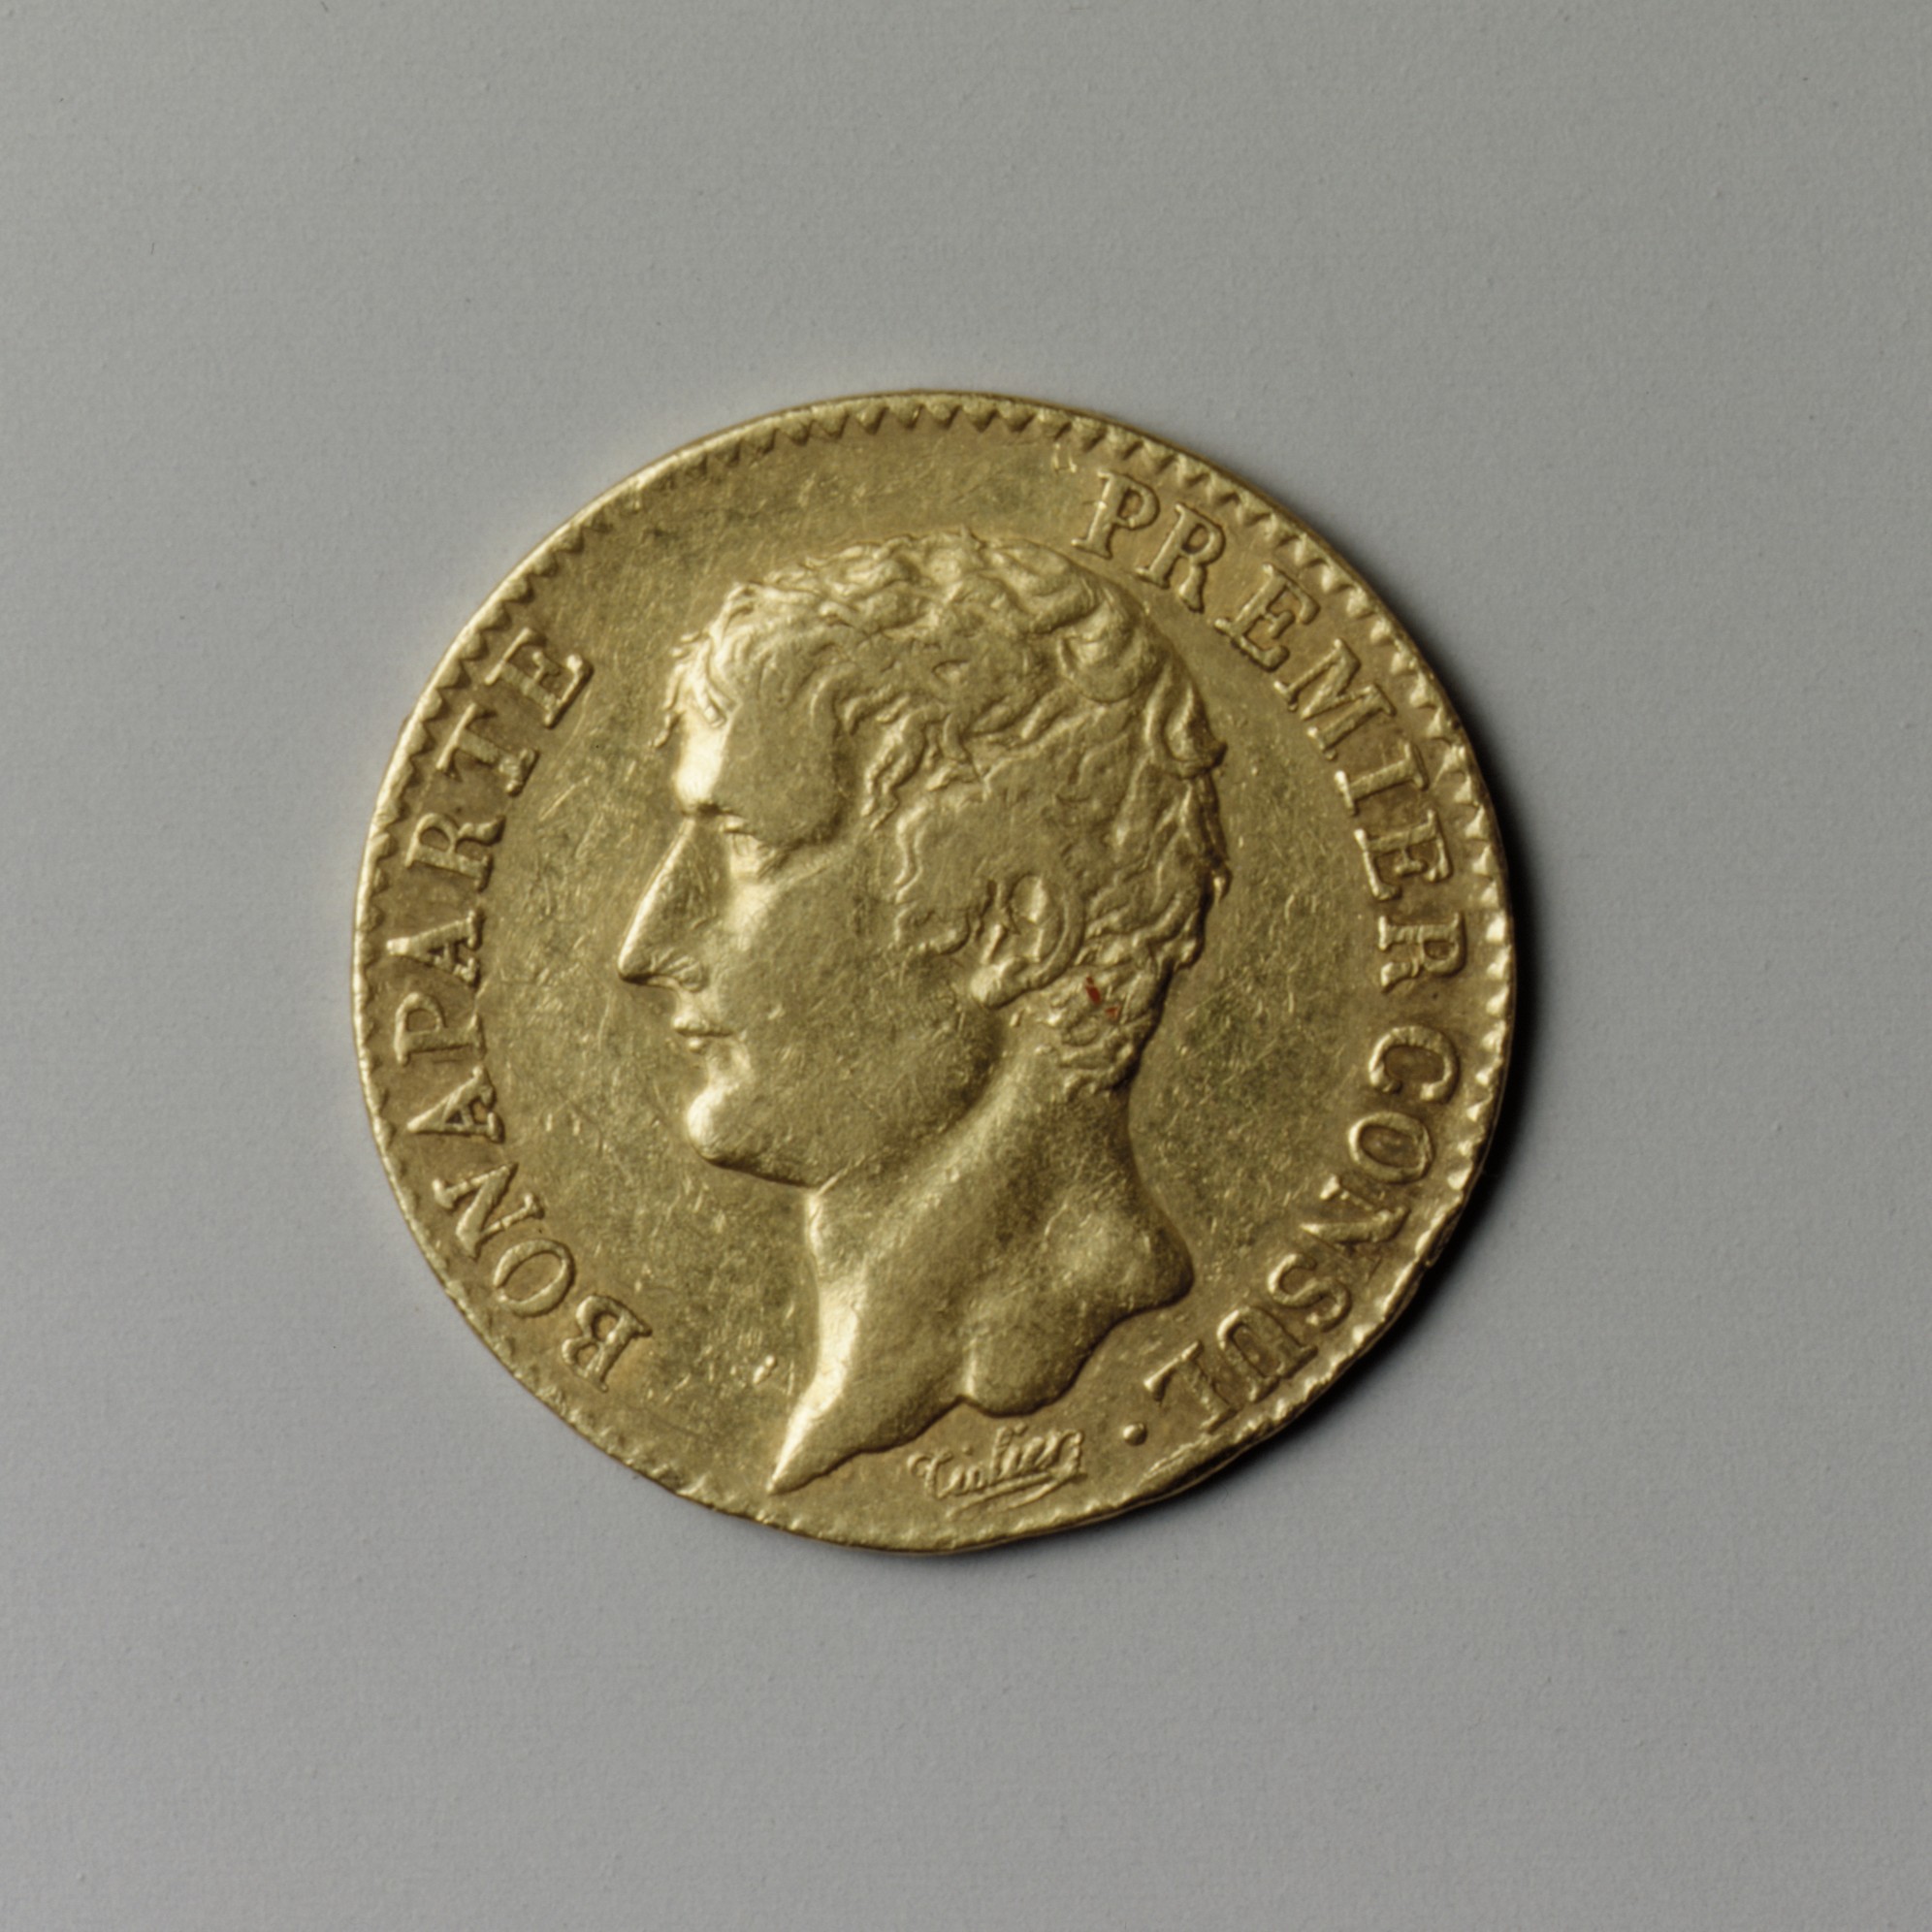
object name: franc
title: 20-franc piece, year 12A, First Consul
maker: nicholas-pierre tiolier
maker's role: artist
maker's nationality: french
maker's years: 1784-1843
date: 1803-1804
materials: gold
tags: men,profiles